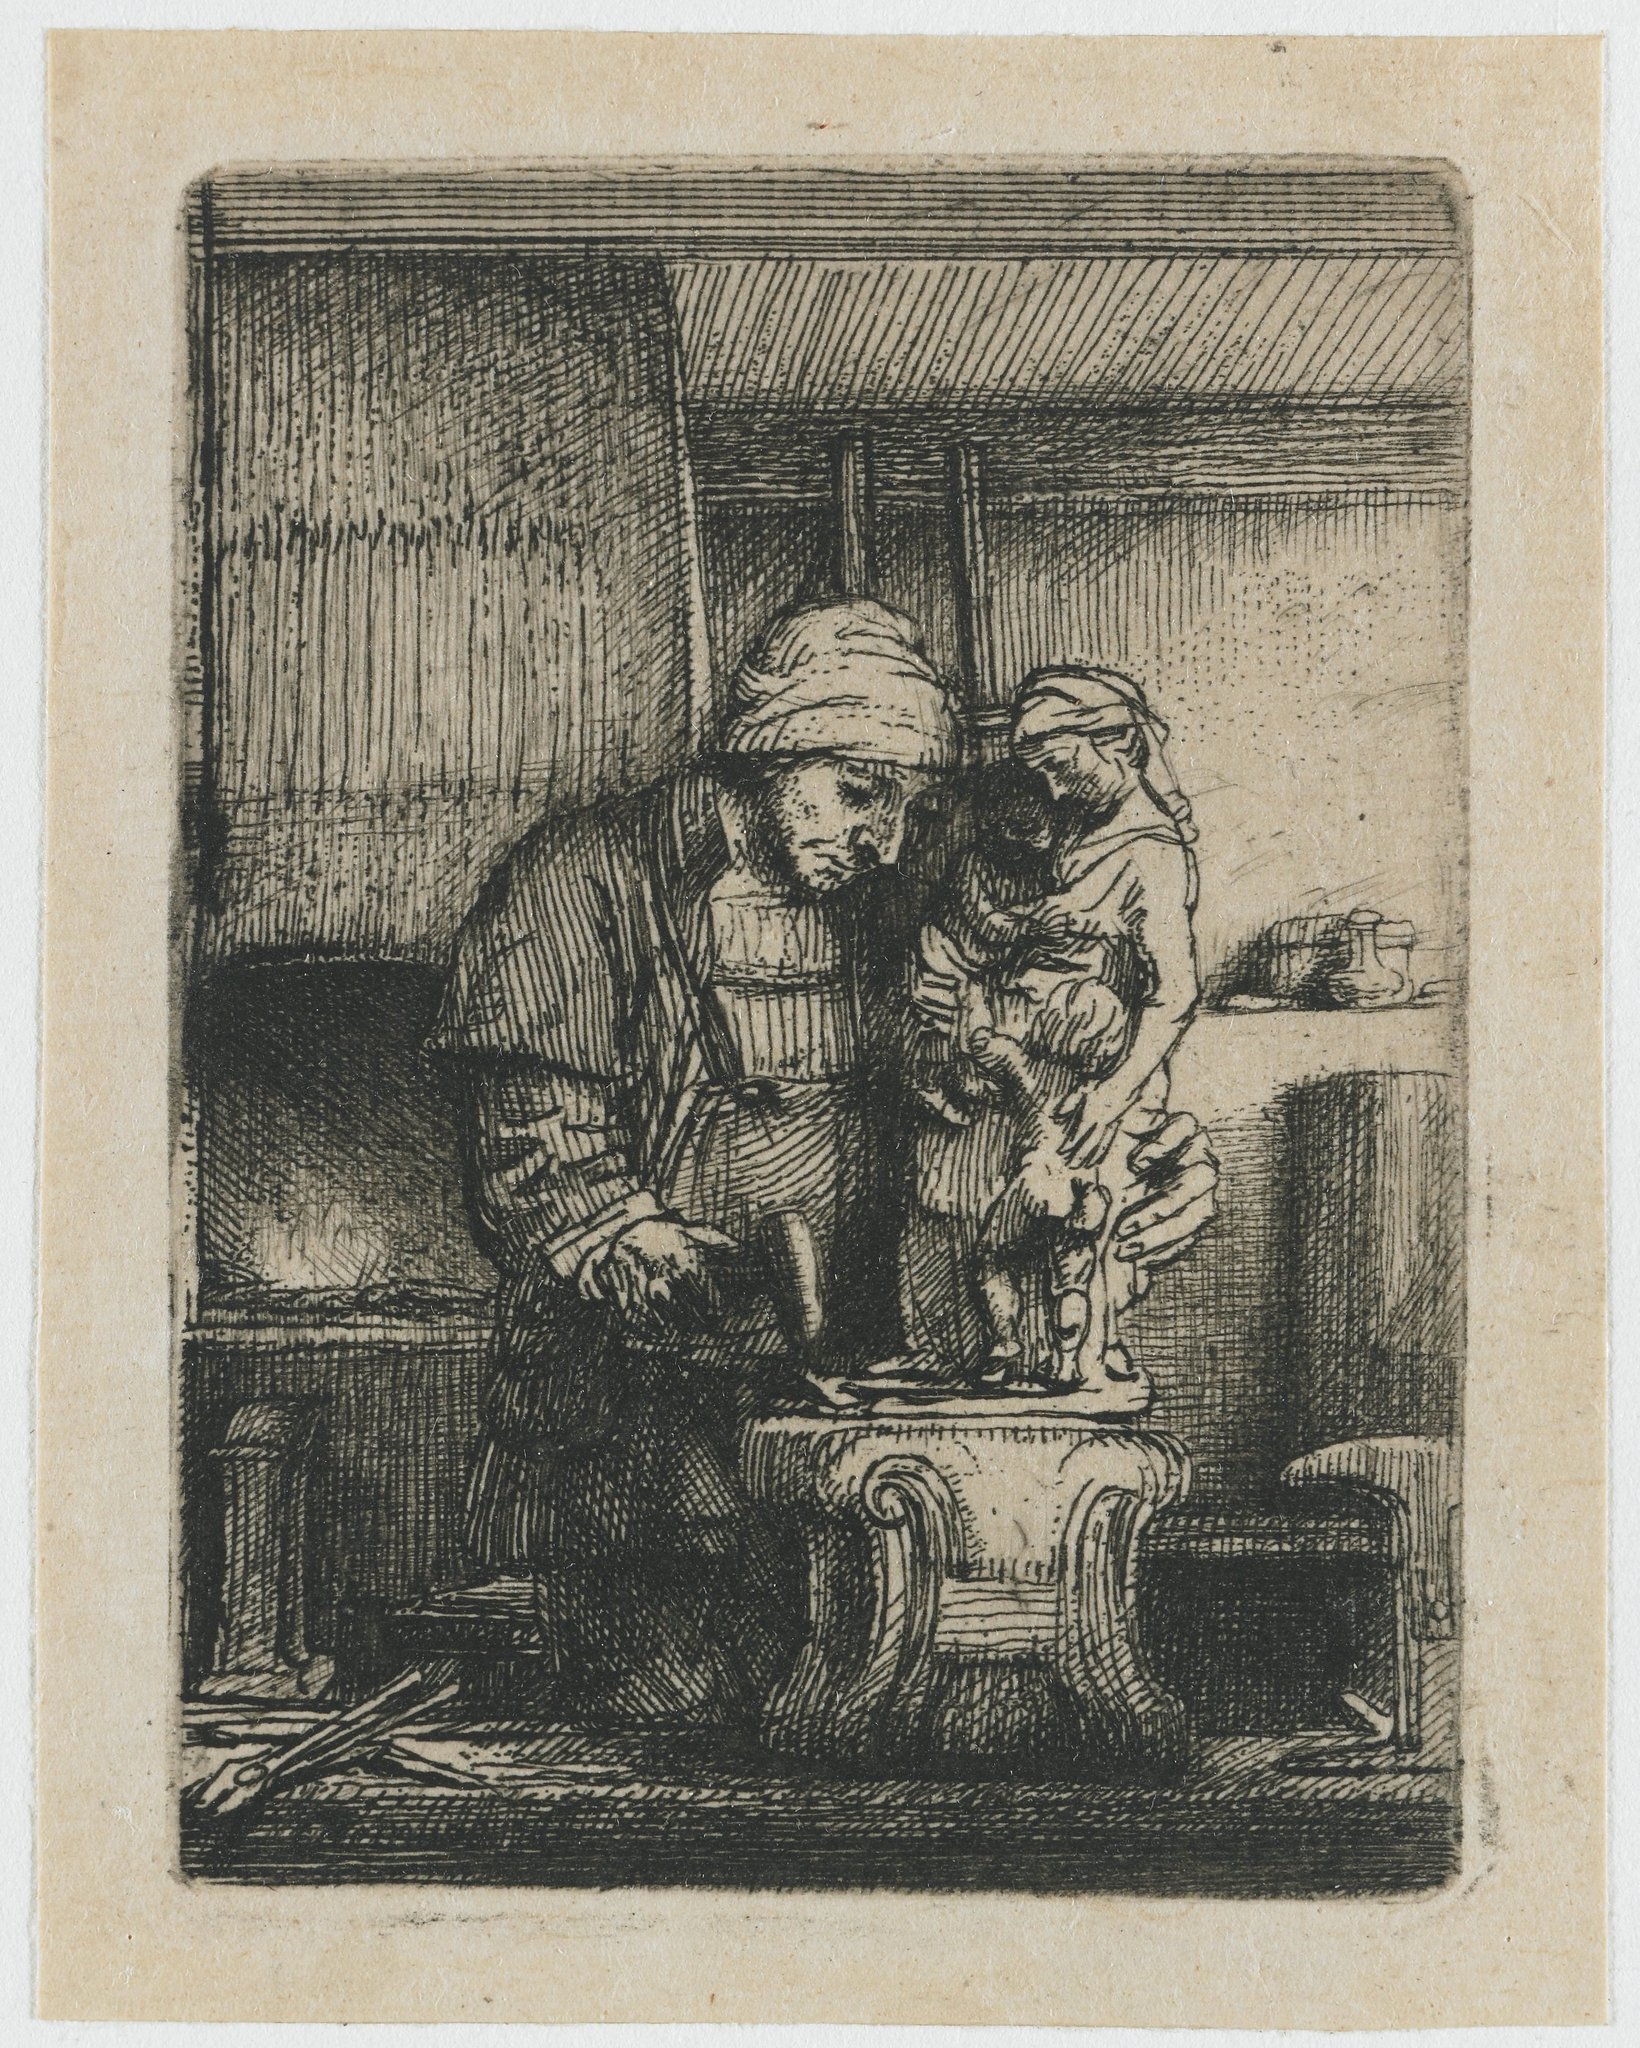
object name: print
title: The goldsmith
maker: rembrandt van rijn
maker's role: draughtsman, painter, print maker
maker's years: 1606-1669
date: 1655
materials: paper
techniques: drypoint, etching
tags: jeweller, goldsmith, silversmith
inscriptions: collector's mark: Lugt 240, signature and date: ‘Rembrandt f. 1655’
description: This tiny etching features a goldsmith hammering away in his workshop, with his tools at the left, an anvil at the right, and a small fire in the forge behind him. His arm is wrapped tenderly around a statuette with which he will soon have to part. The mother, symbolizing Charity, holds her two children just as lovingly.